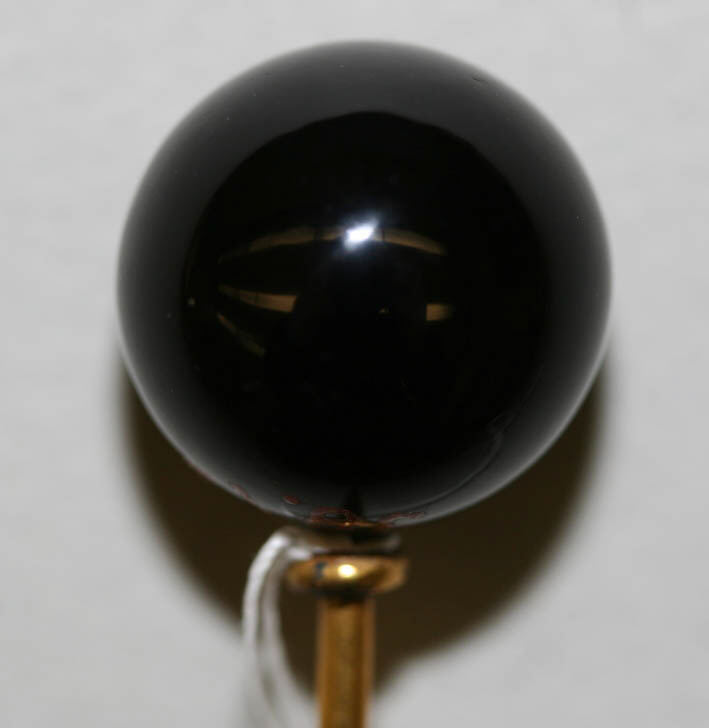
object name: hatpin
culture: french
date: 1801-2000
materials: porcelain